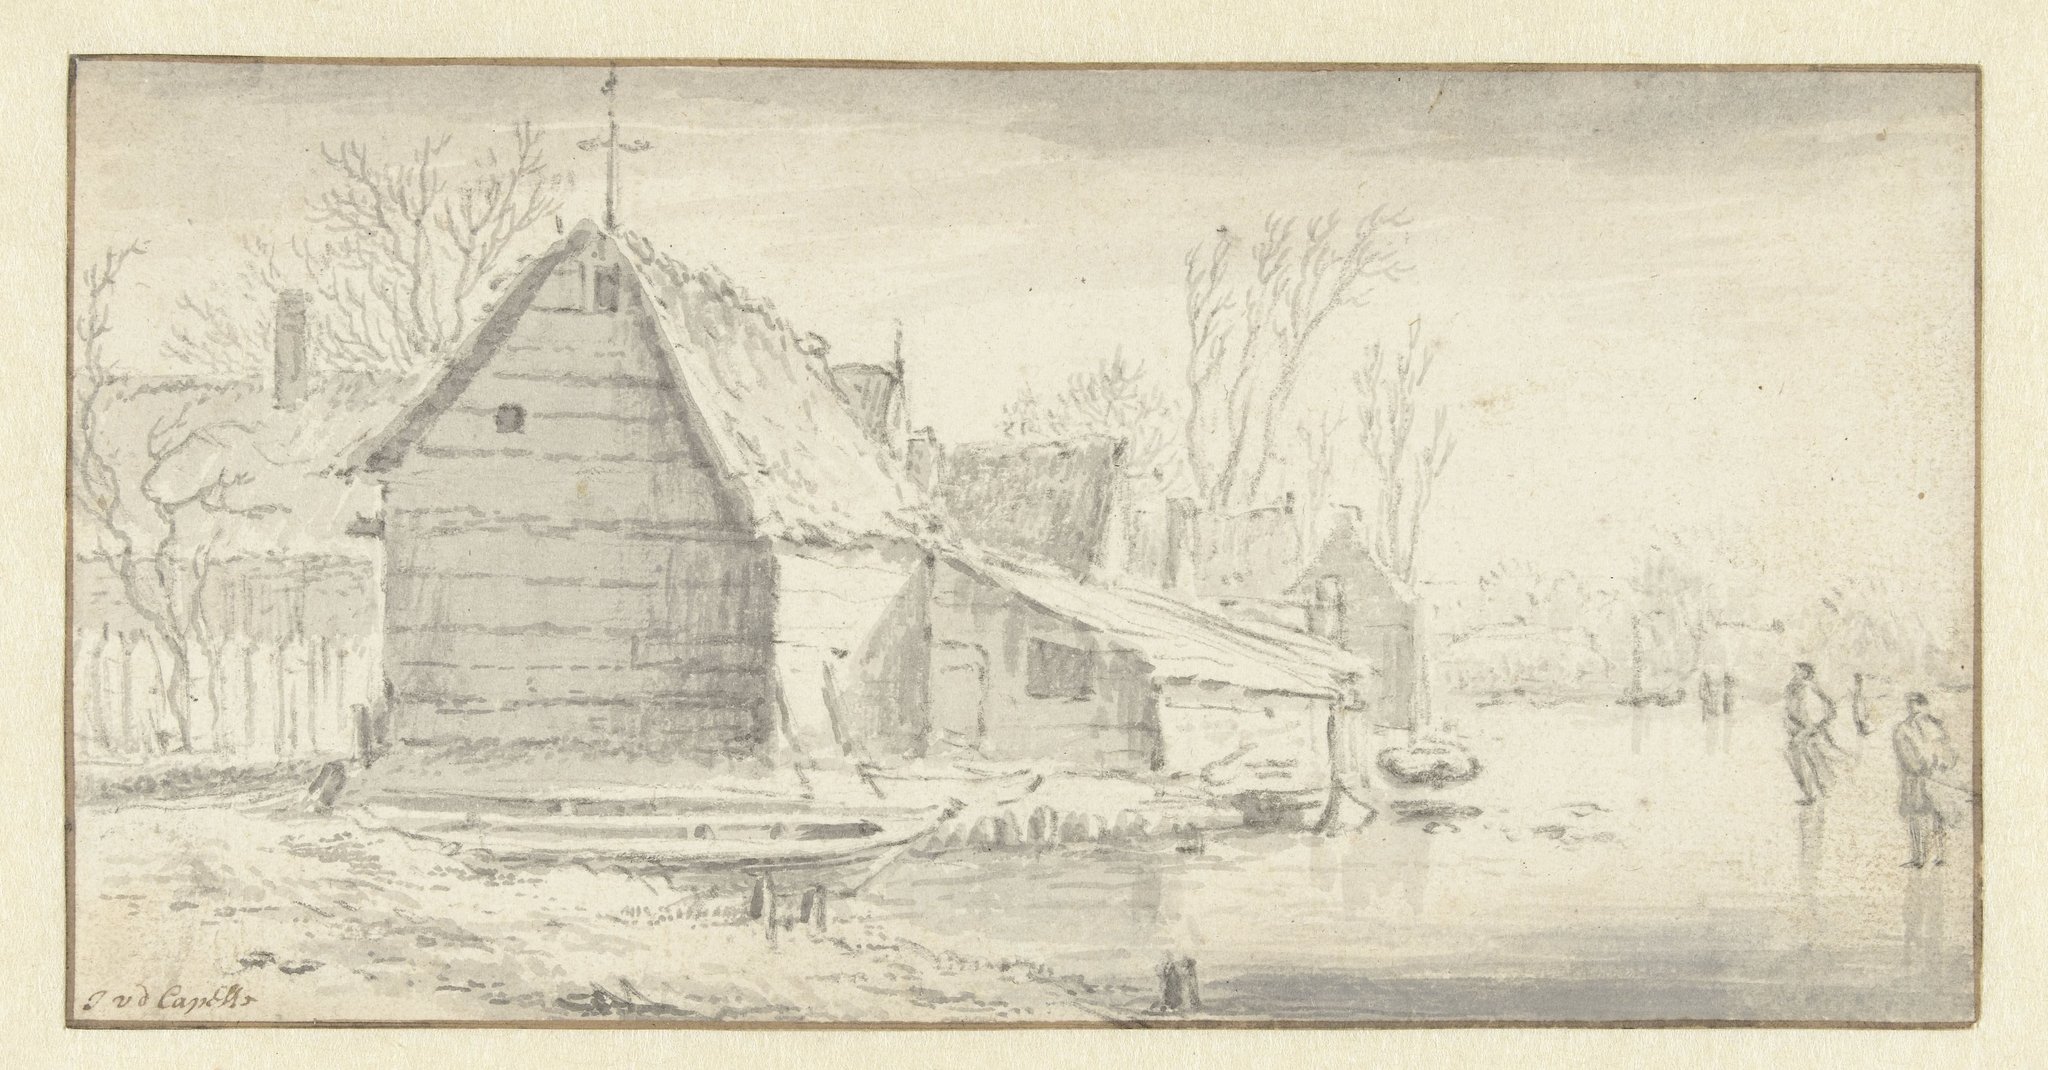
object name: drawing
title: Wintergezicht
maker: jan van de cappelle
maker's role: draughtsman, print maker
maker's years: 1624-1679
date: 1634-1679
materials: chalk, paper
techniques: brush